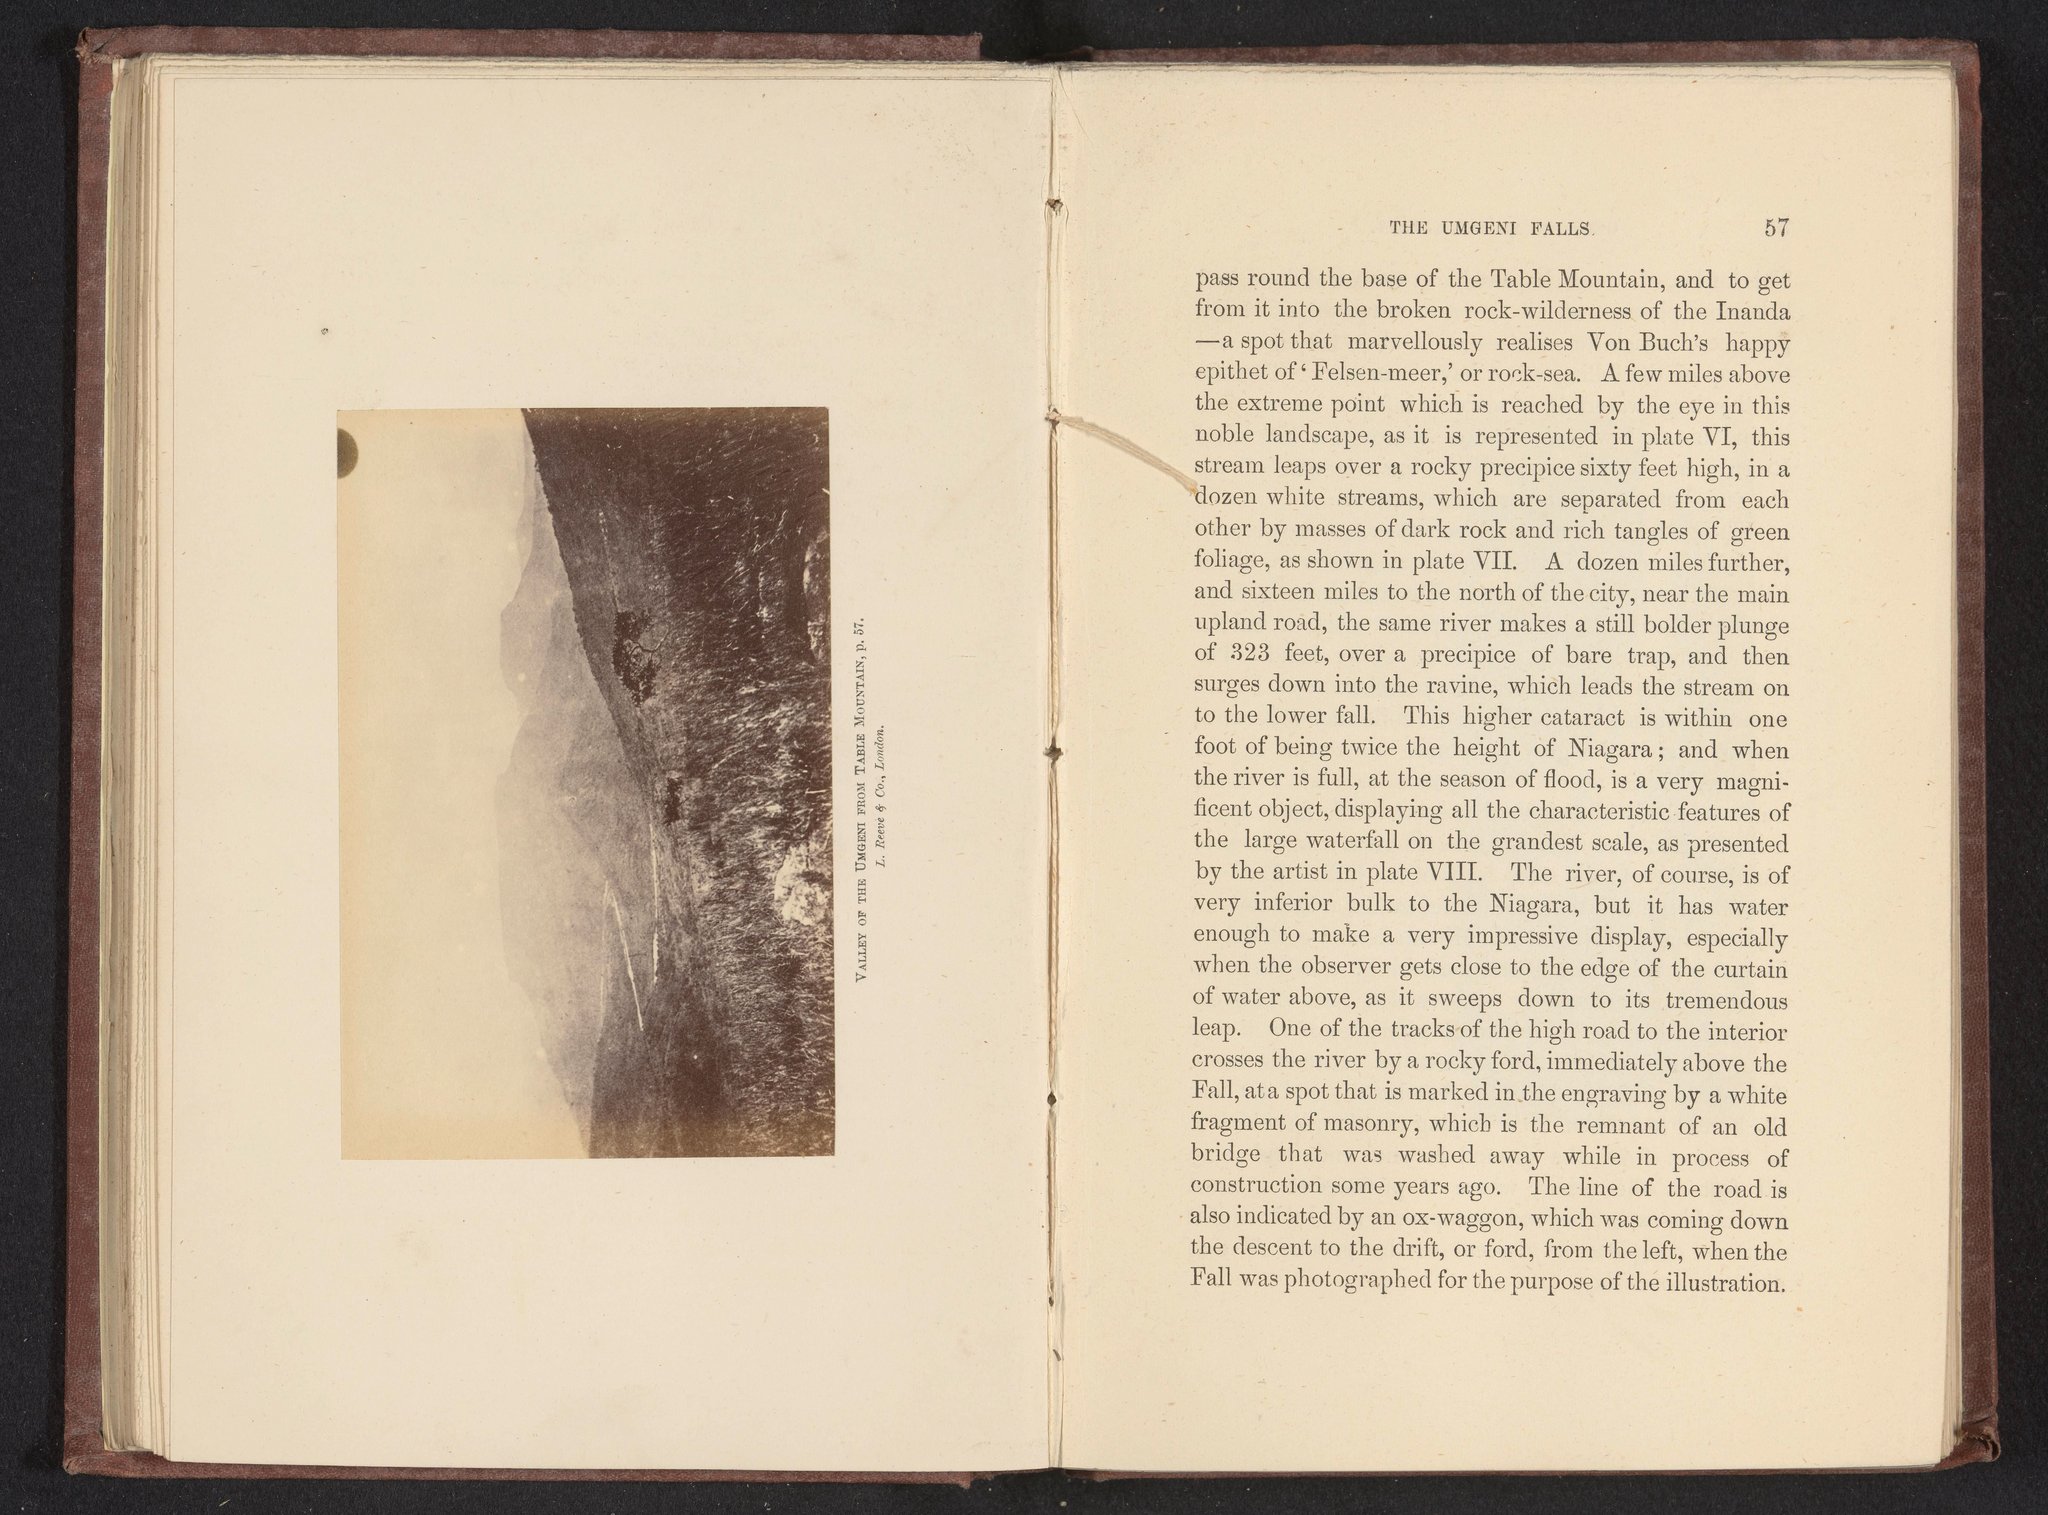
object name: page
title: Valley of the Umgeni from Table Mountain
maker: Anonymous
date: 1866-1876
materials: photographic support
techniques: albumen print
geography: natal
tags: dale, valley, river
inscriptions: name: ‘L. Reeve & Co., London.’